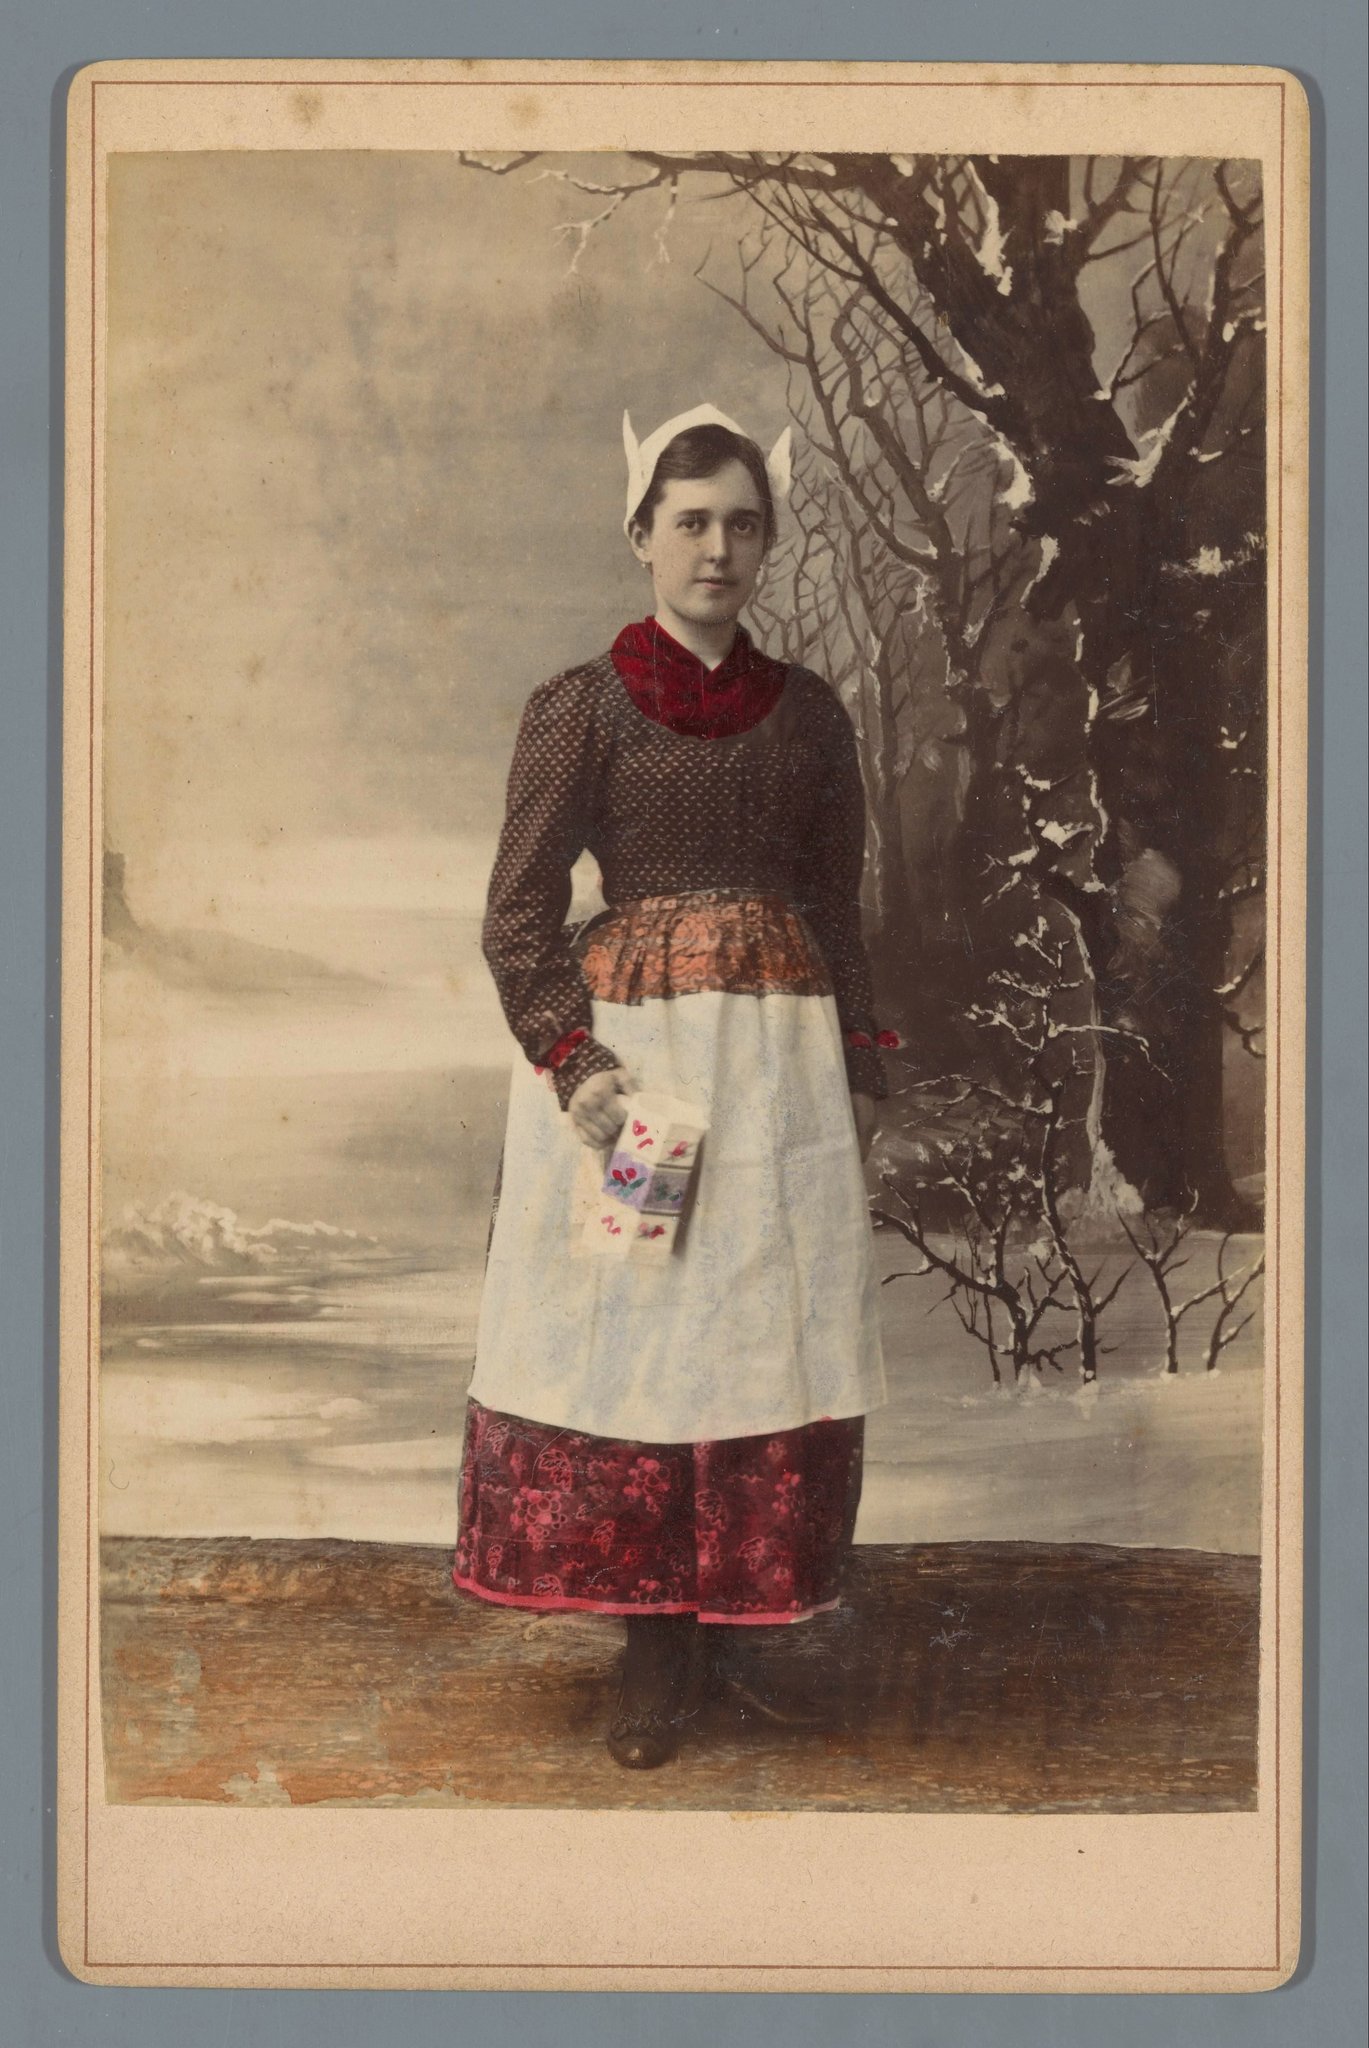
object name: cabinet photograph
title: Portret van Isa Rodenburg van Heyst in klederdracht met een kan in haar hand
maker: Anonymous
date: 1880-1900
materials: cardboard, photographic support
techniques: albumen print, hand coloring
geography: netherlands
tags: folk costume, regional costume, container of ceramics: jar, jug, pot, vase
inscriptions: name: ‘Isa Rodenburg van Heyst’